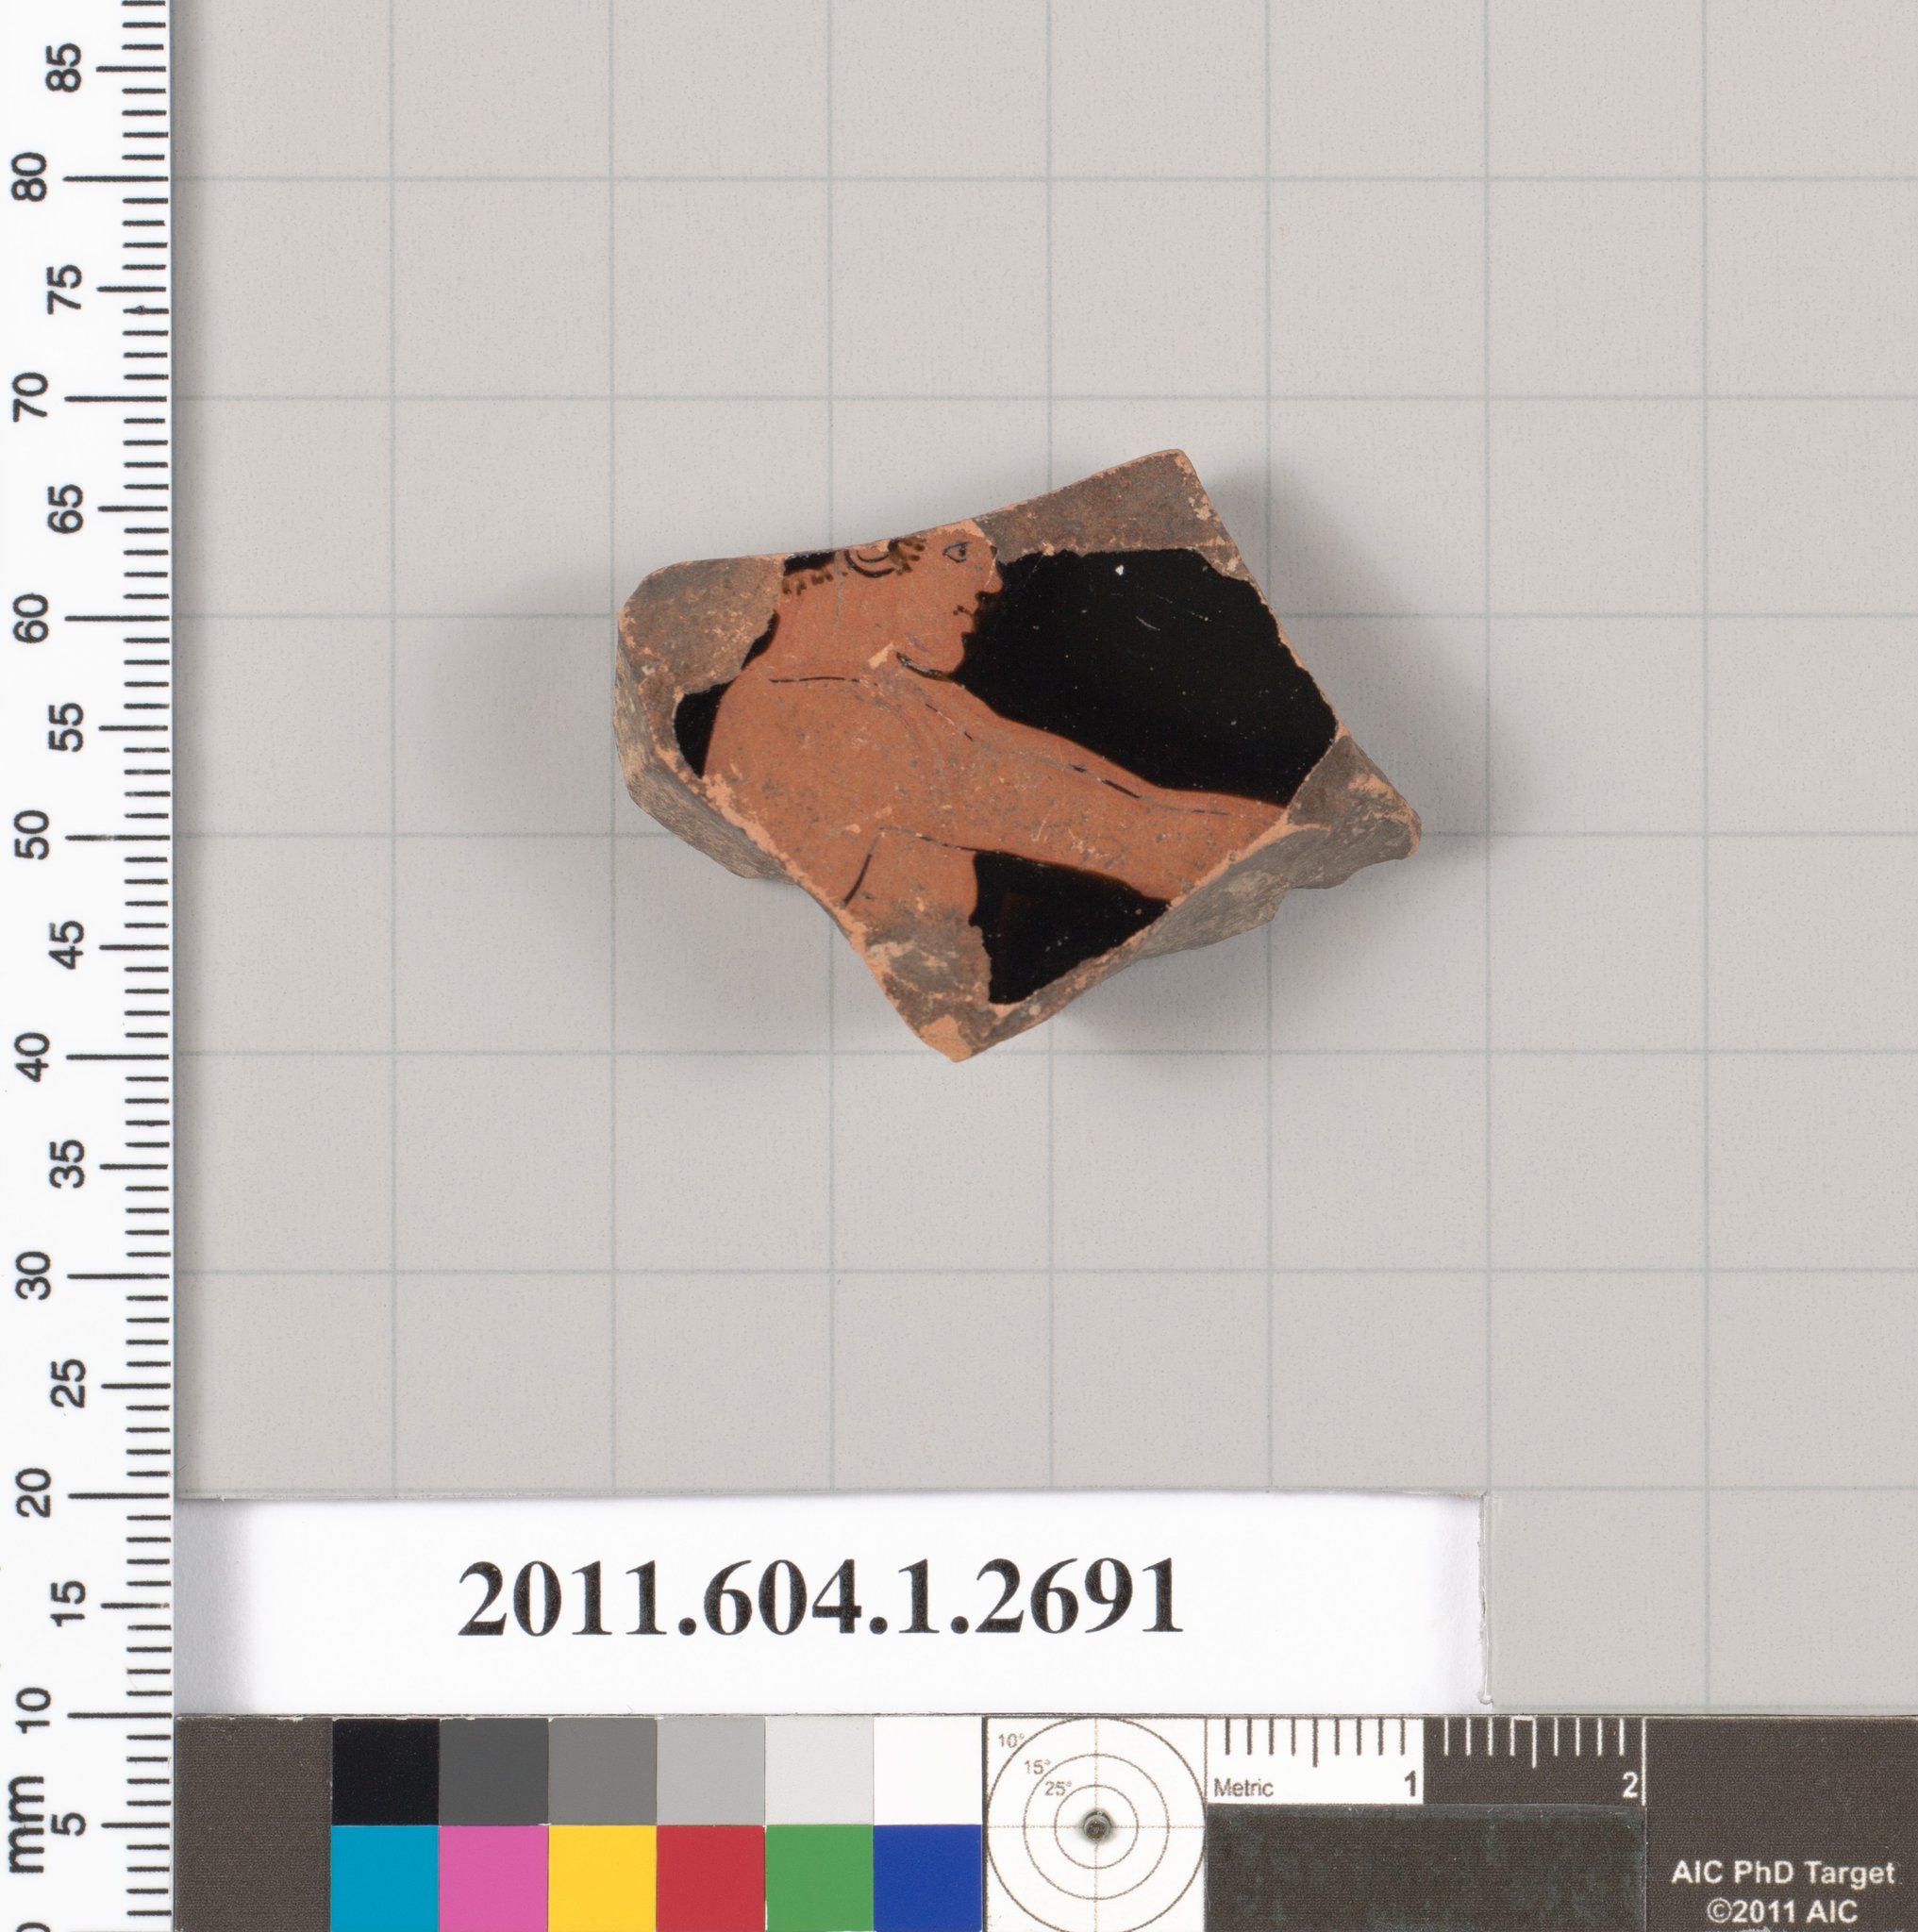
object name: kylix fragment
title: Terracotta fragment of a kylix (drinking cup)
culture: greek, attic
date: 490-470 BCE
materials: terracotta